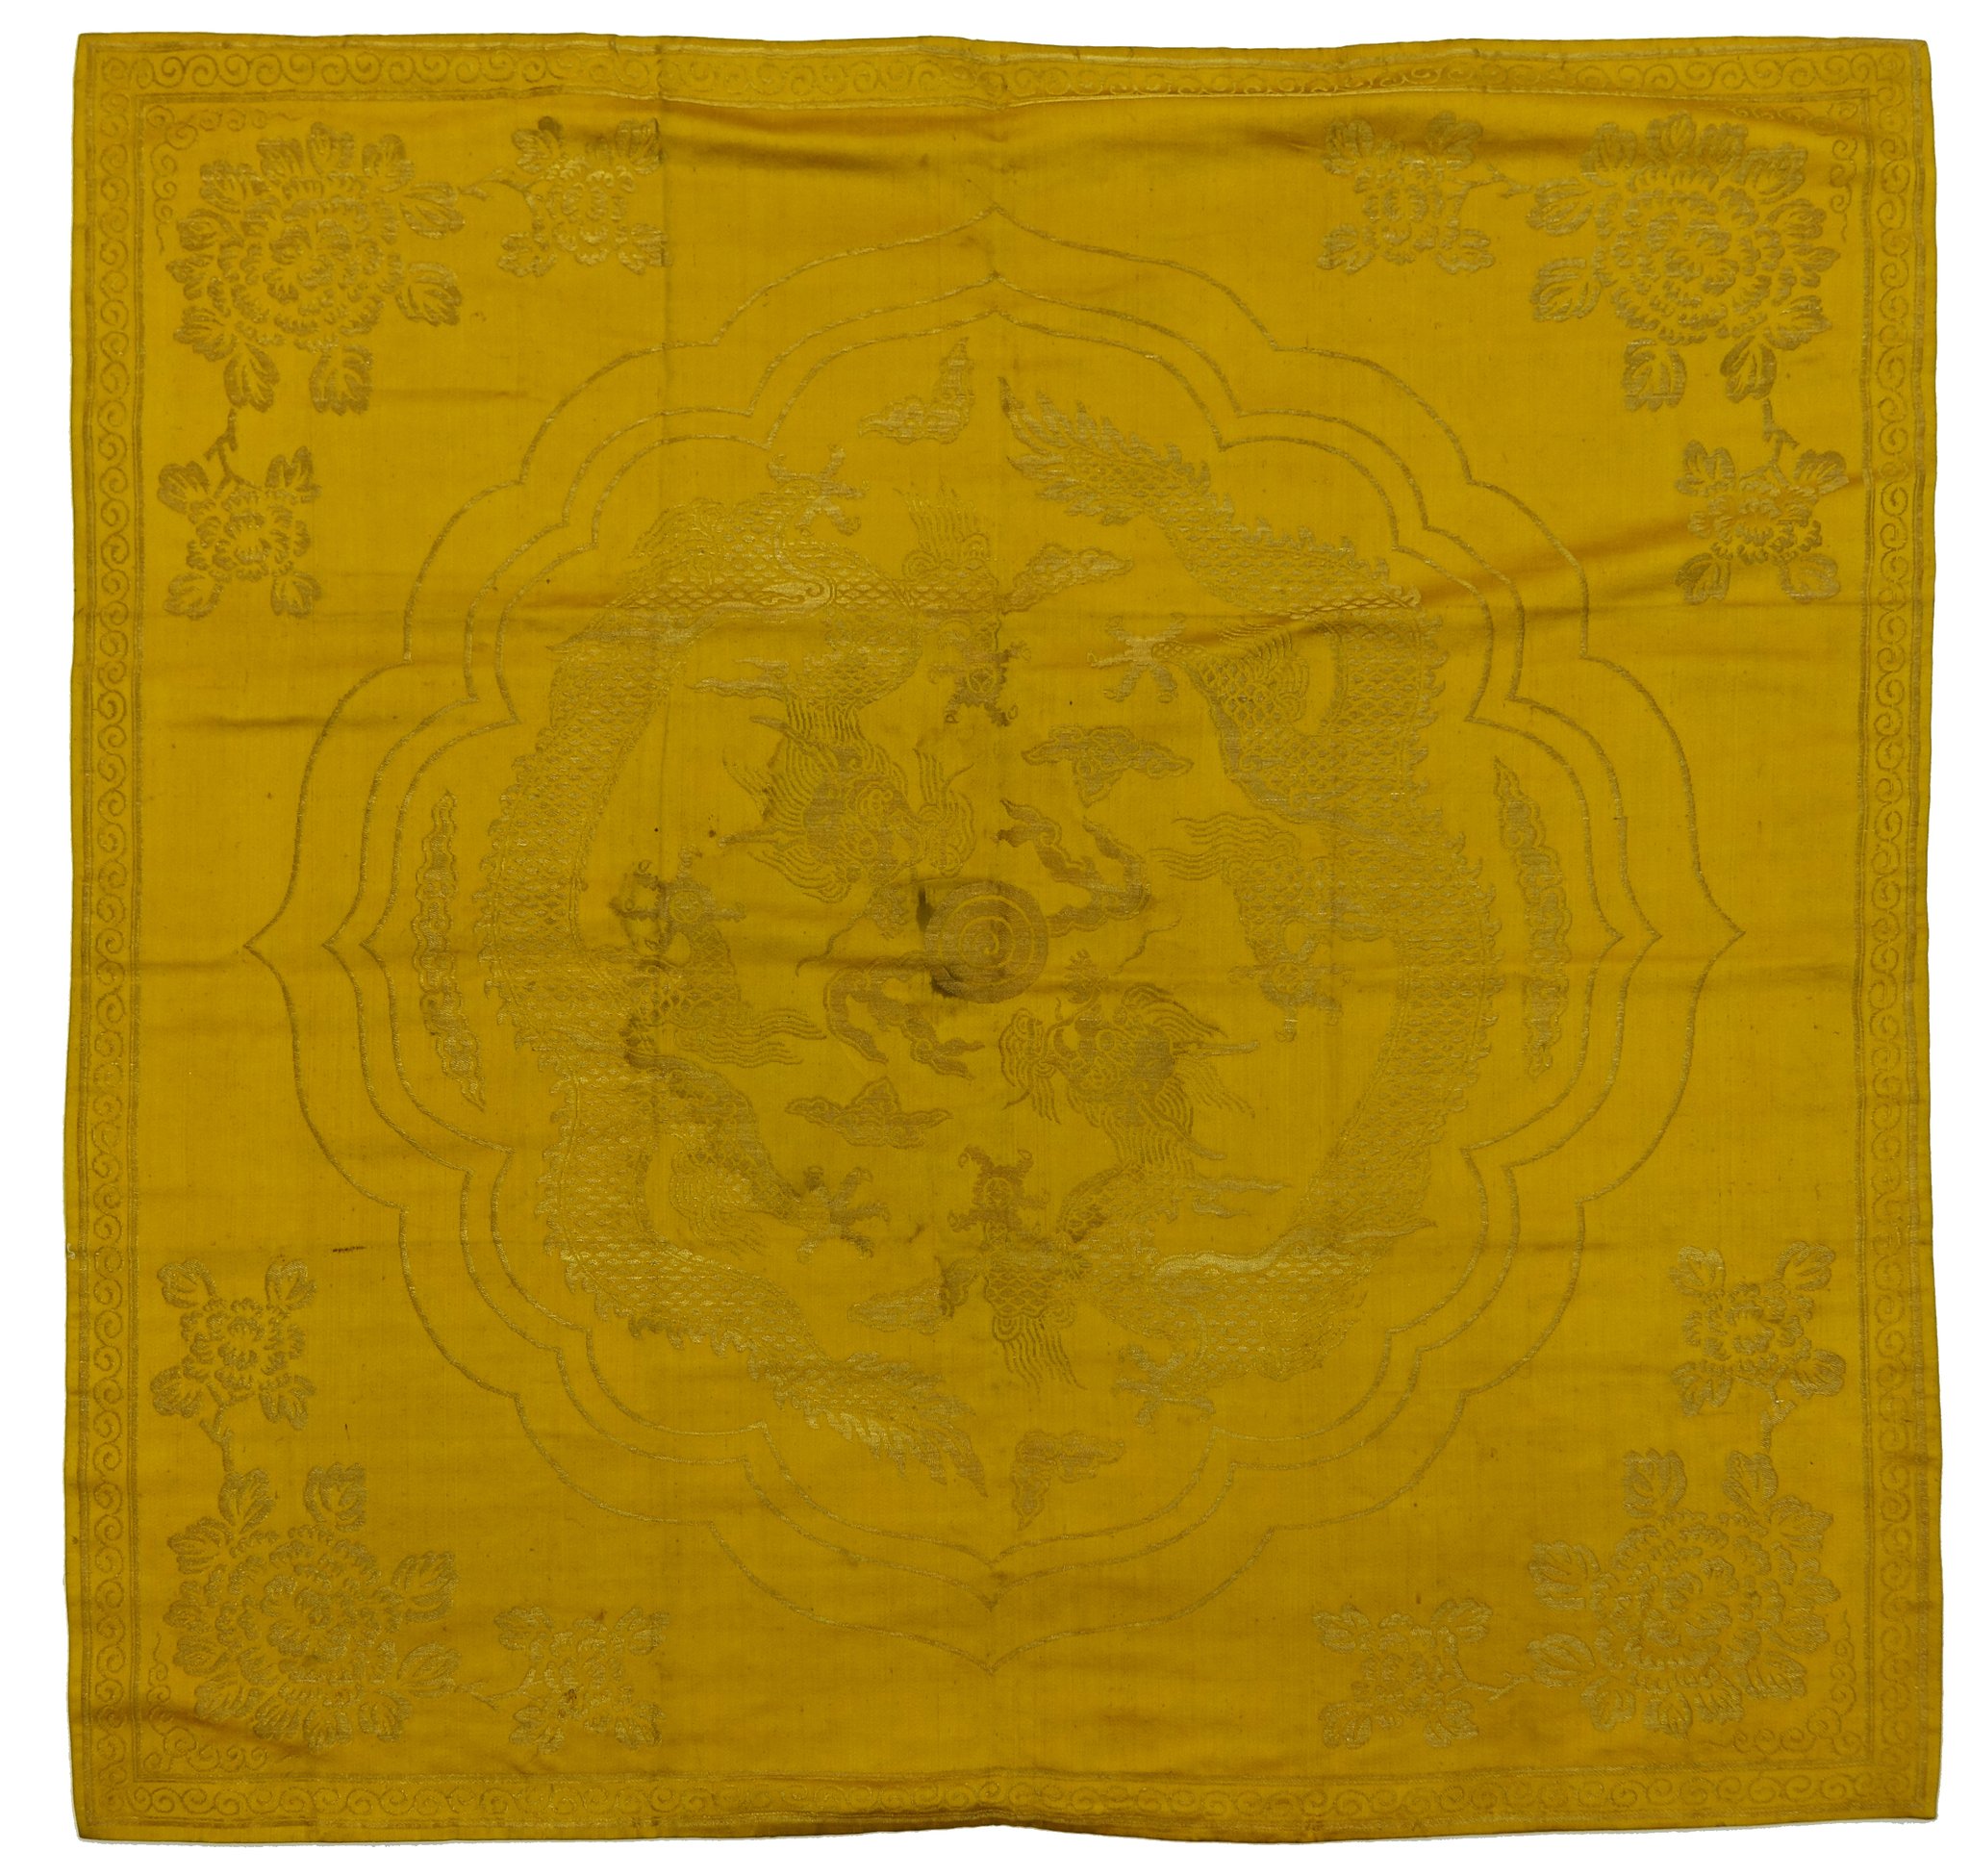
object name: wrapping cloth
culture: chinese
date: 1875-1908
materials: metal thread, silk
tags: dragons